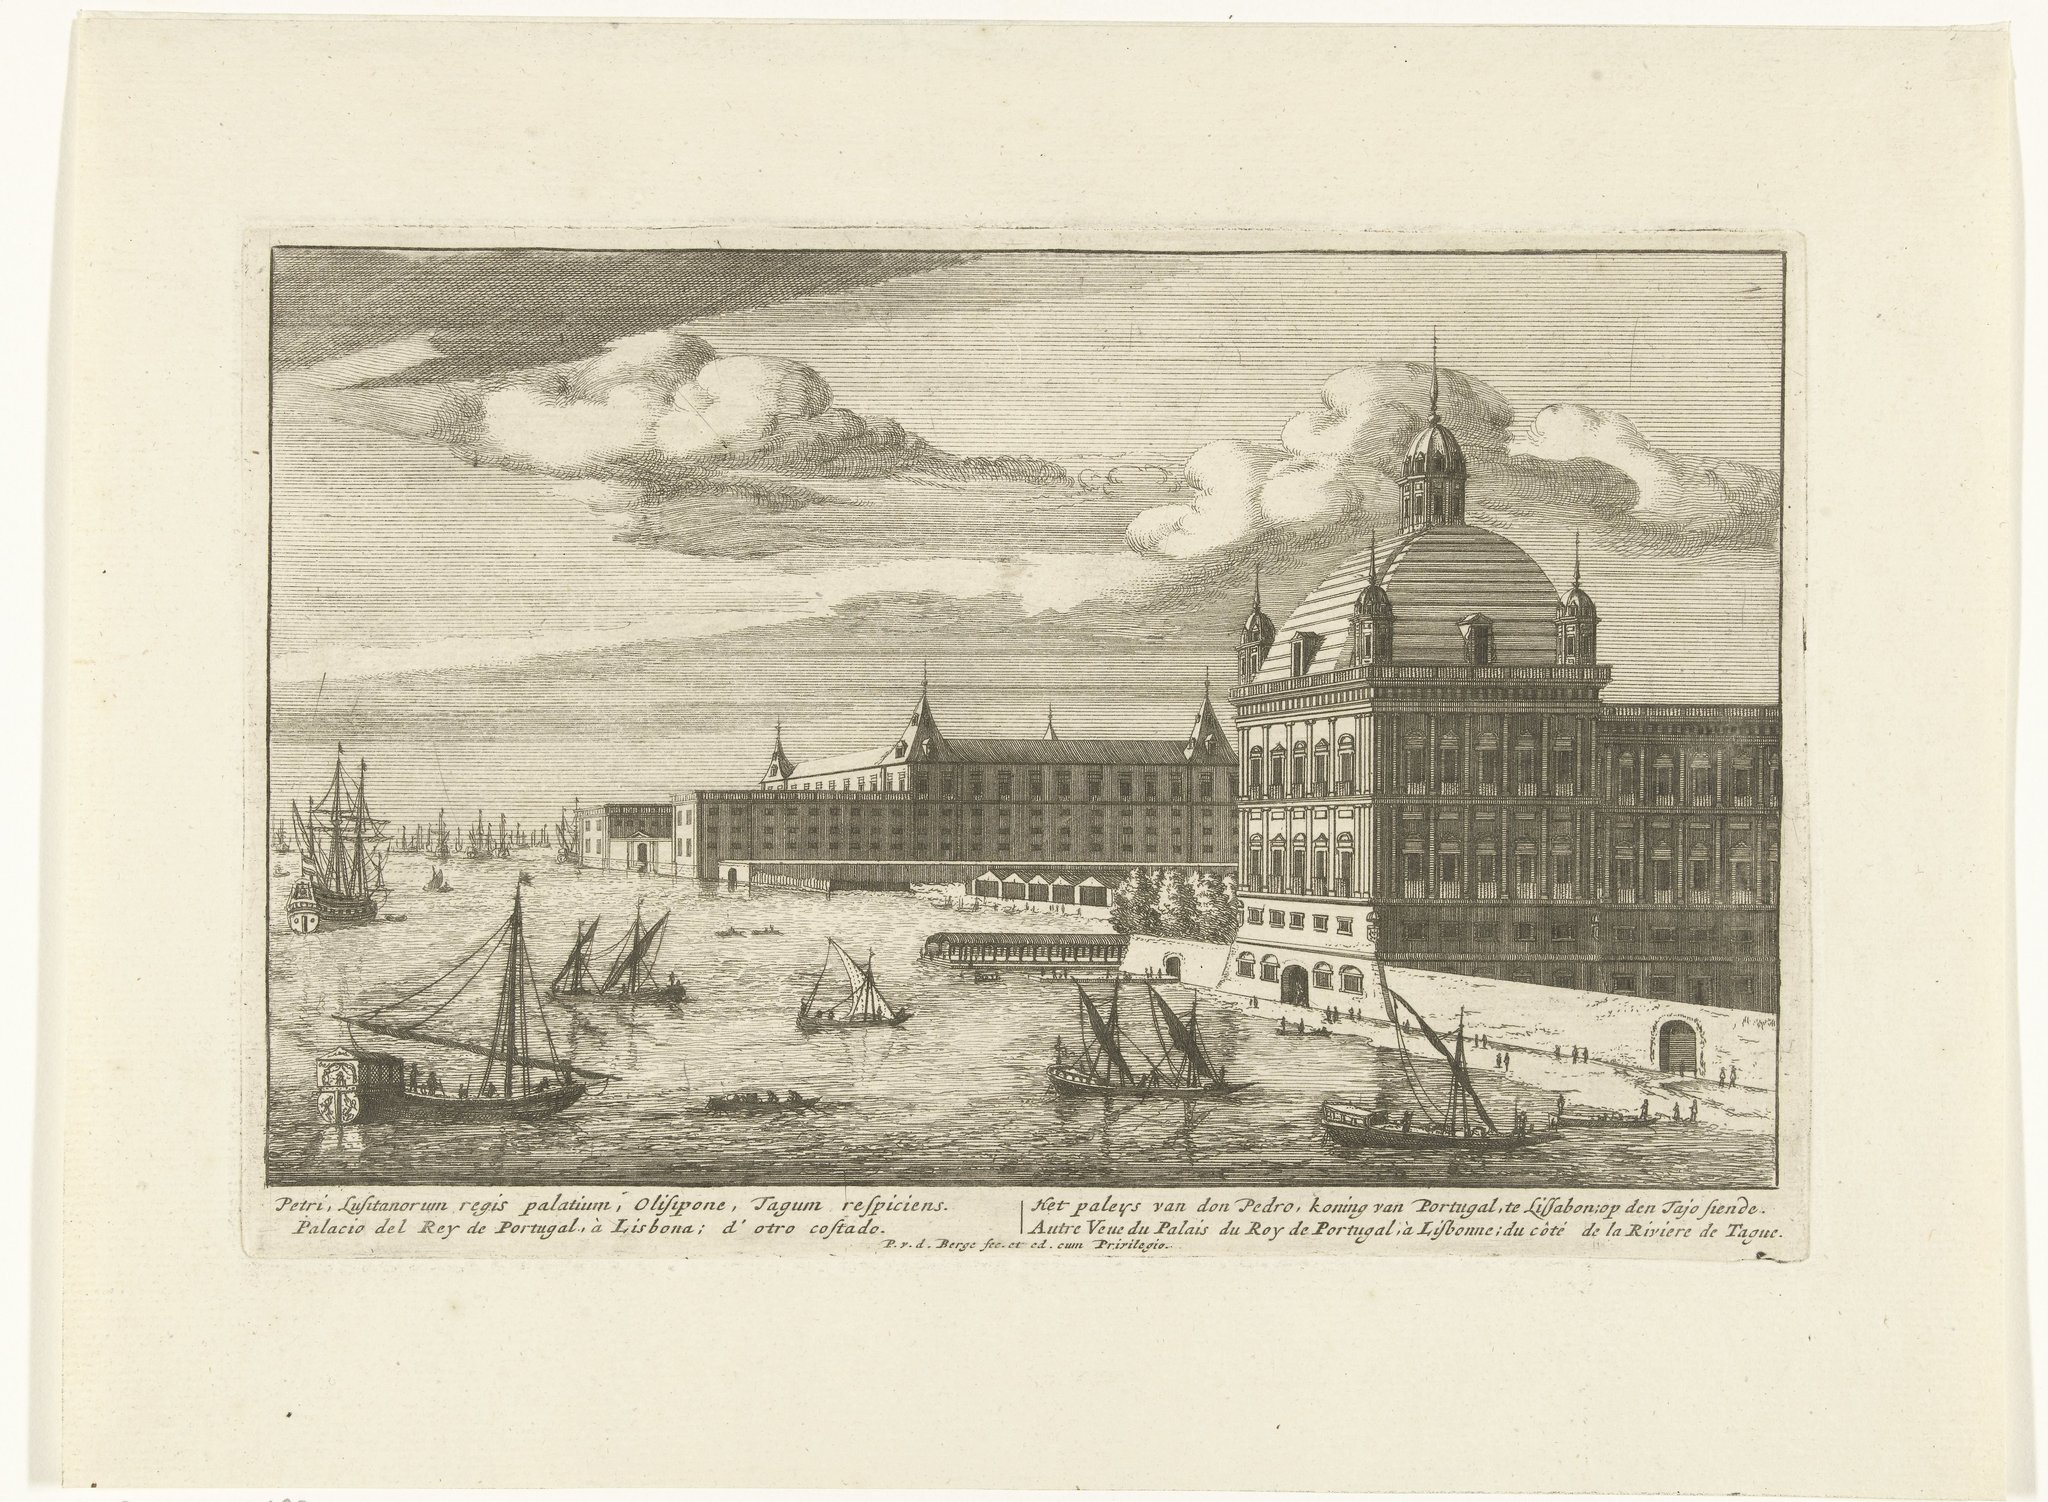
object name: print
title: Het paleys van don Pedro, koning van Portugal, te Lissabon, op den Tajo siende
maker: pieter van den berge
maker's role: draughtsman, print maker, printer, publisher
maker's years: 1659-1737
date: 1694-1737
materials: paper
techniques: etching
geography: amsterdam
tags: paco da ribeira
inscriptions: collector's mark: Lugt 2228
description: Prent uit: Theatrum Hispaniæ, exhibens regni urbes, villas ac viridaria magis illustria. Het aanmerkelykste en voortreffelykste in Spanjen (...). Amsterdam: Pieter van den Berge, ca. 1694-1737.